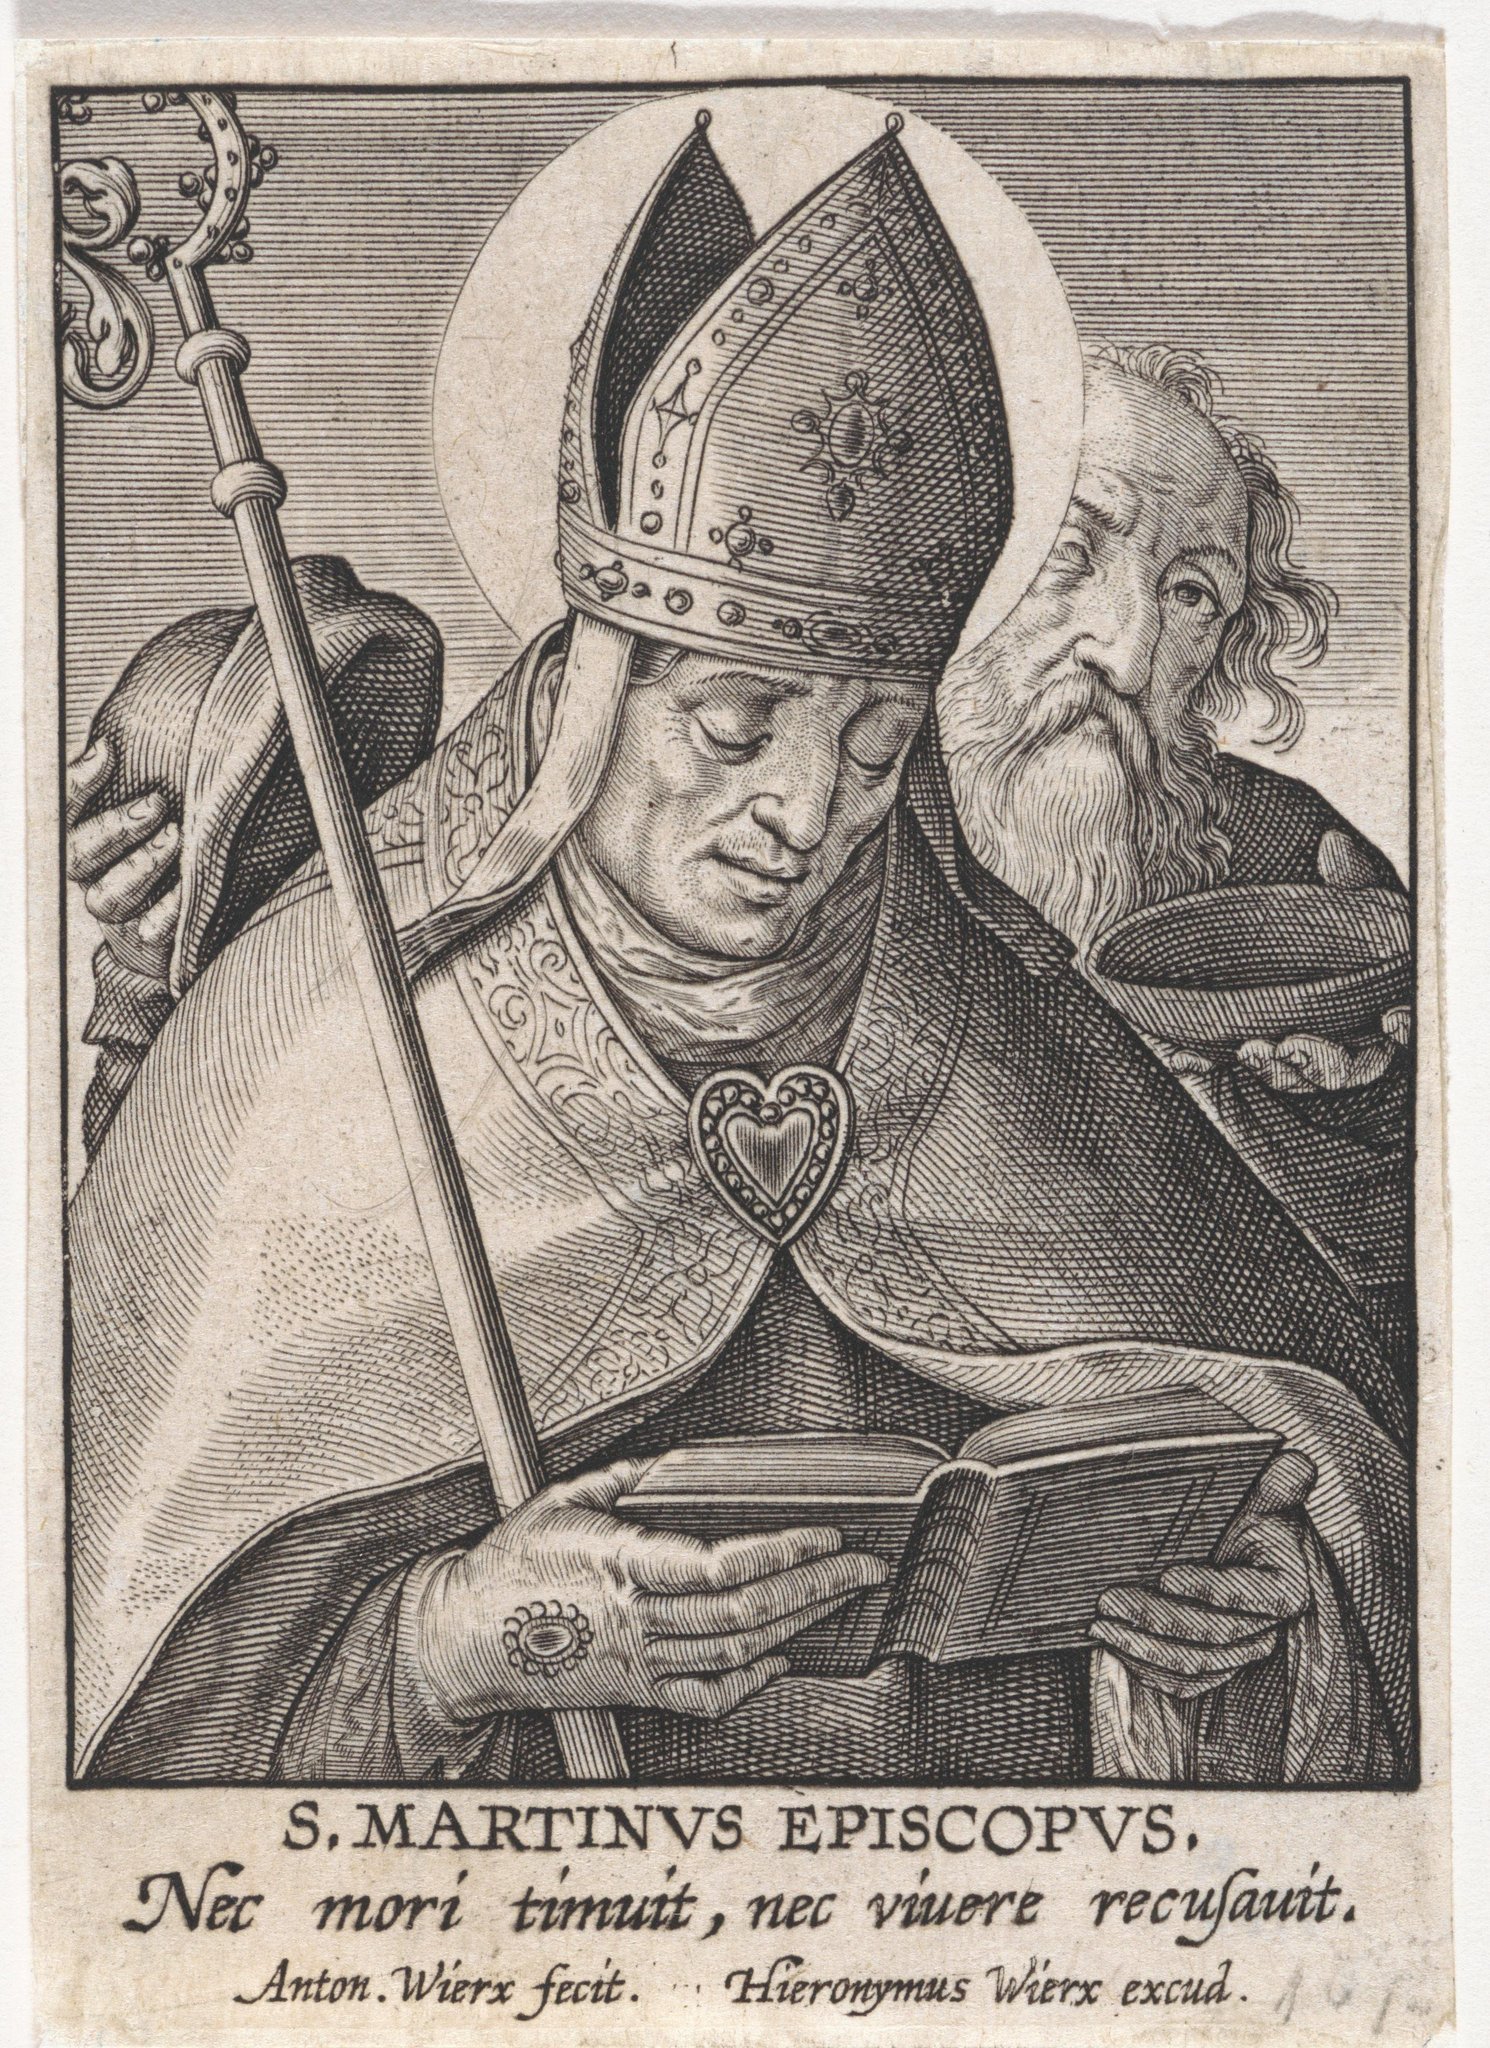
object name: print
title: H. Martinus van Tours als bisschop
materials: paper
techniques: engraving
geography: antwerp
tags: beggar, martin(us), bishop of tours; possible attributes: beggar, goose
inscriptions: collector's mark: Lugt 2542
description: De heilige Martinus van Tours draagt zijn bisschopsgewaad en leest in een boek. Achter hem een zwerver. In de marge een onderschrift in het Latijn.